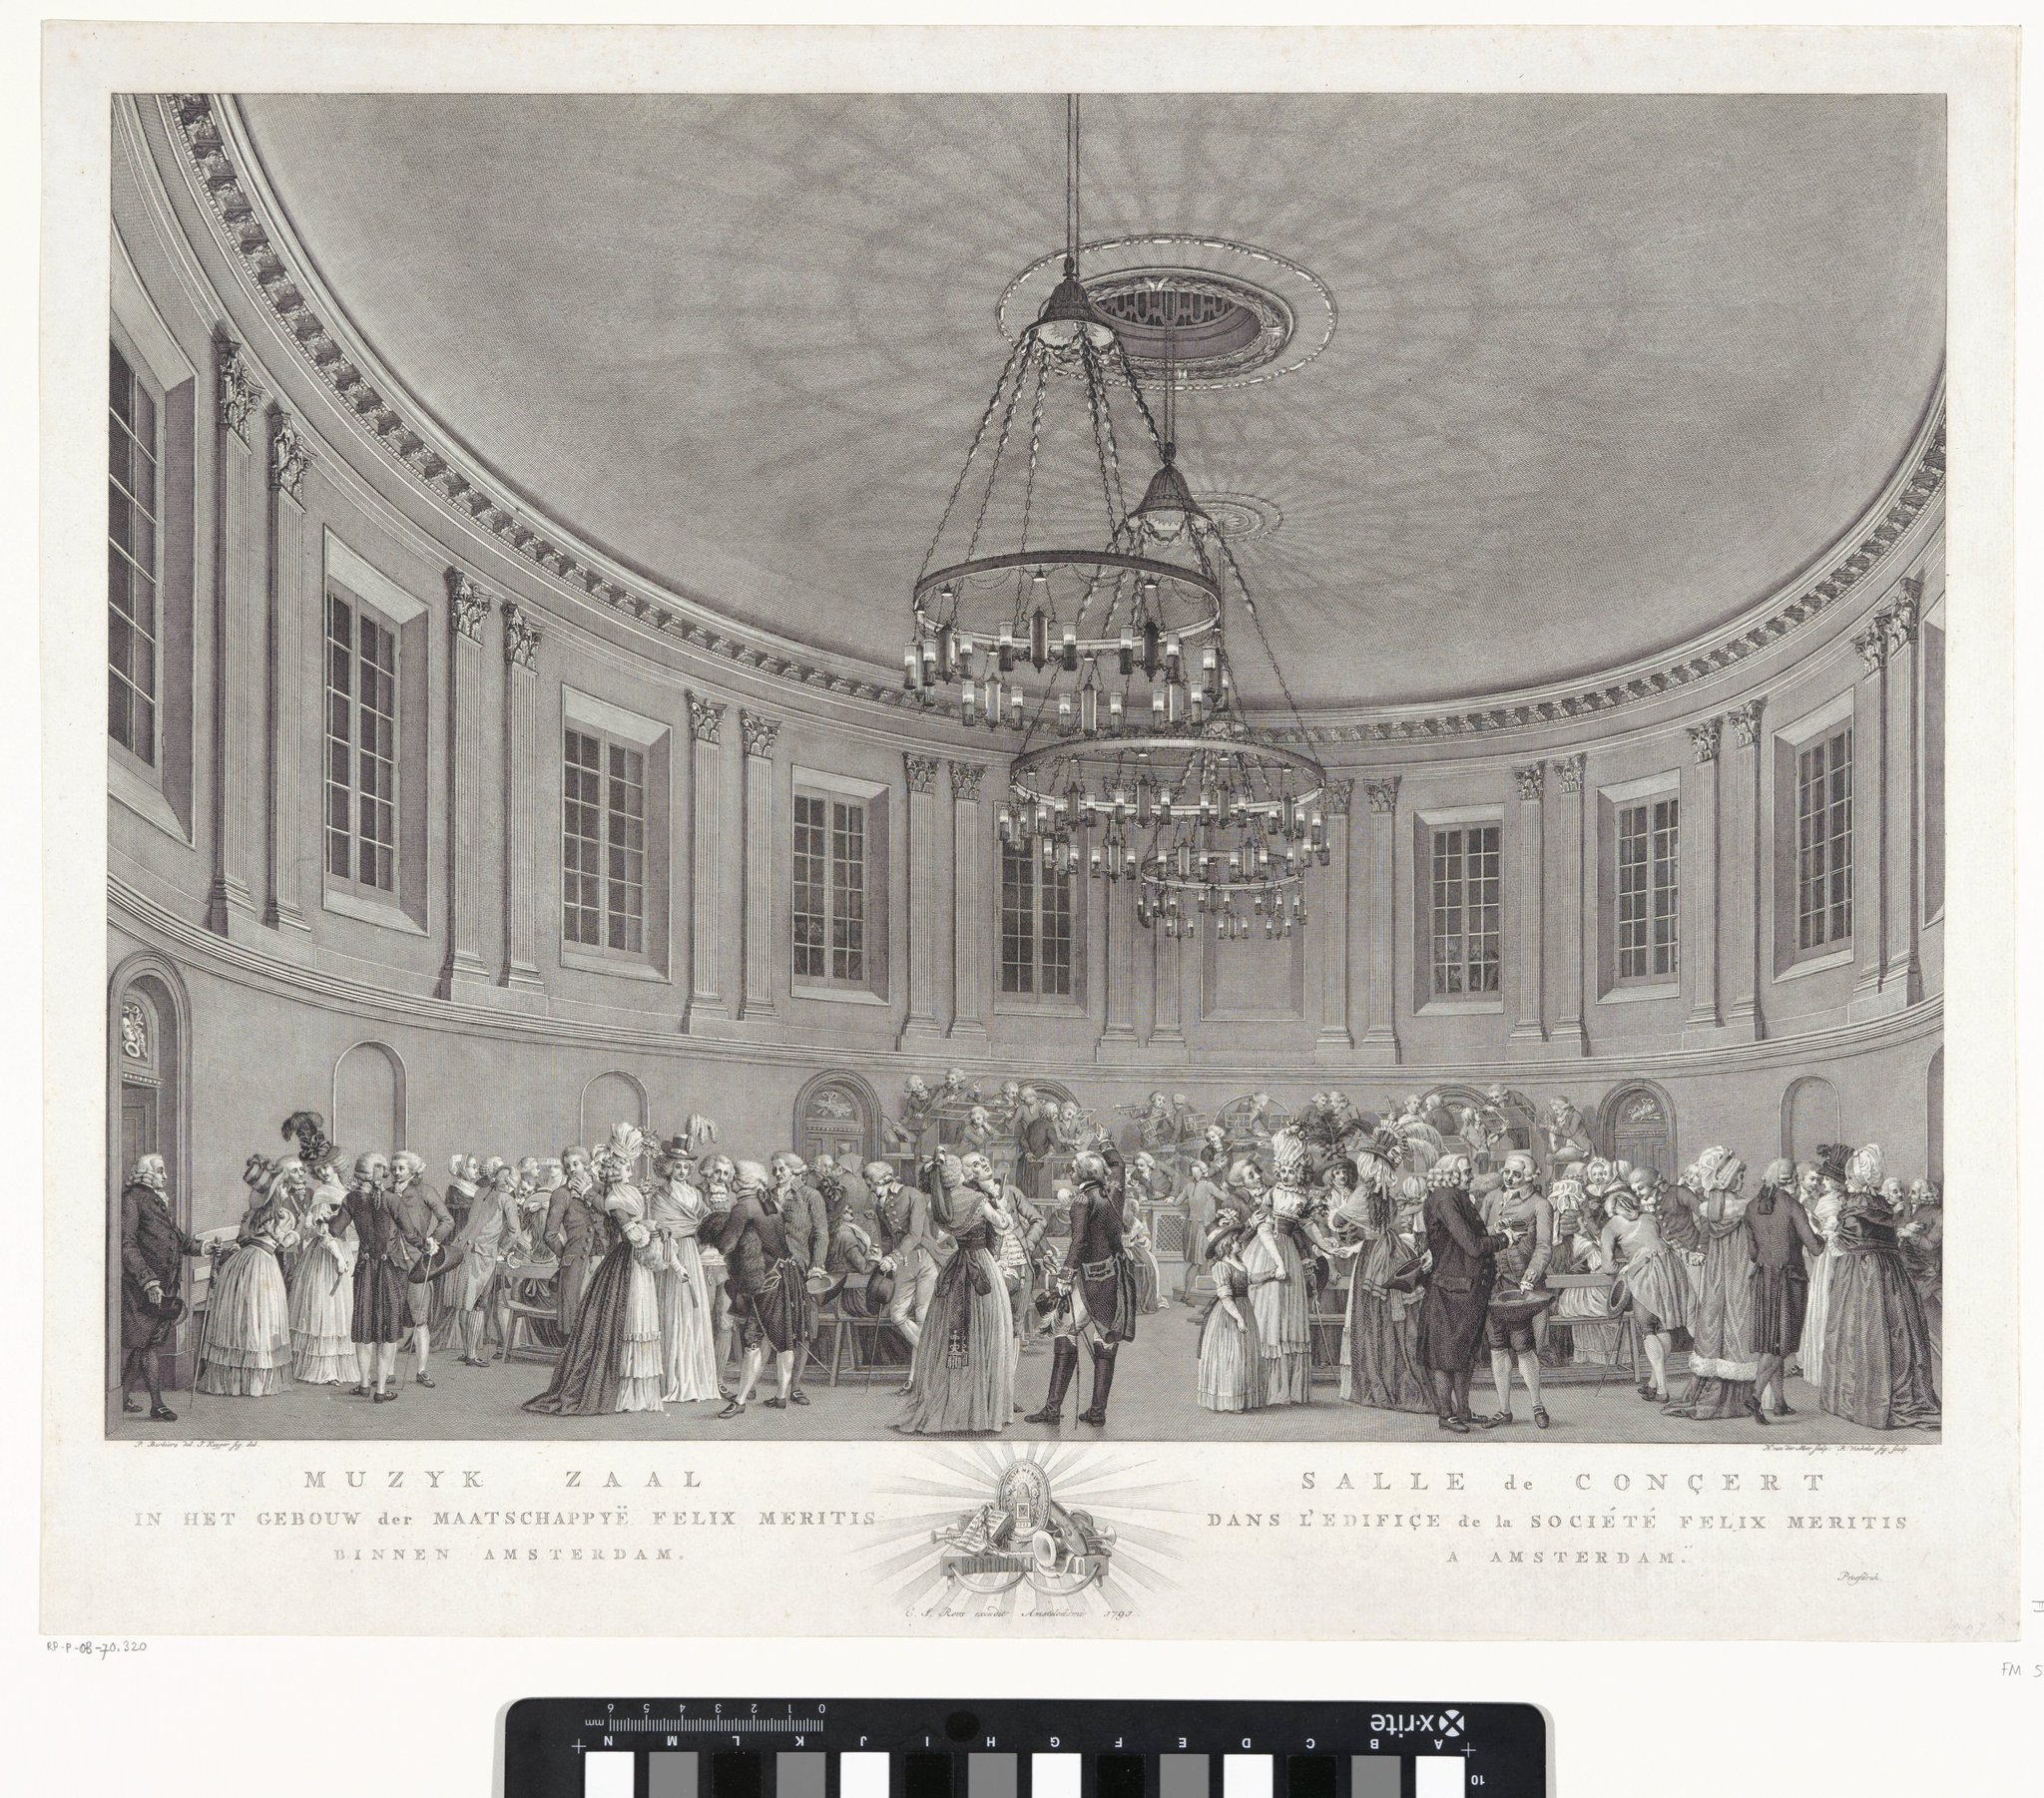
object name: print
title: Vier zalen in Felix Meritis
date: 1791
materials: paper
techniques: engraving, etching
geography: amsterdam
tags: learned society, academy of sciences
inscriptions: date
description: Bezoekers in de Concertzaal in het gebouw van de maatschappij Felix Meritis te Amsterdam, ingewijd in 1789.